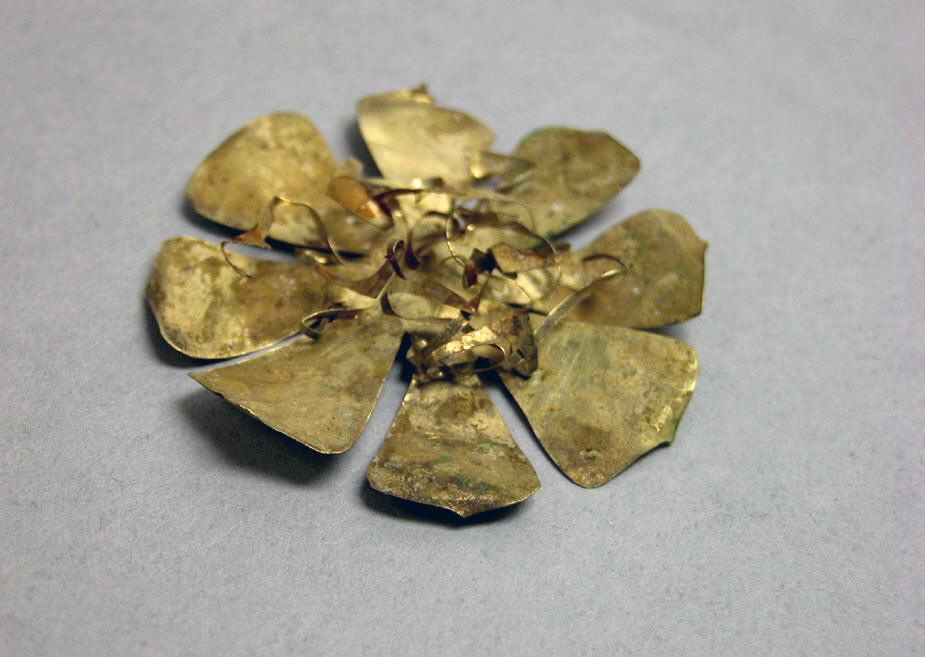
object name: ornament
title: Lotus (Pripih)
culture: indonesian, javanese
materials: gold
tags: lotuses